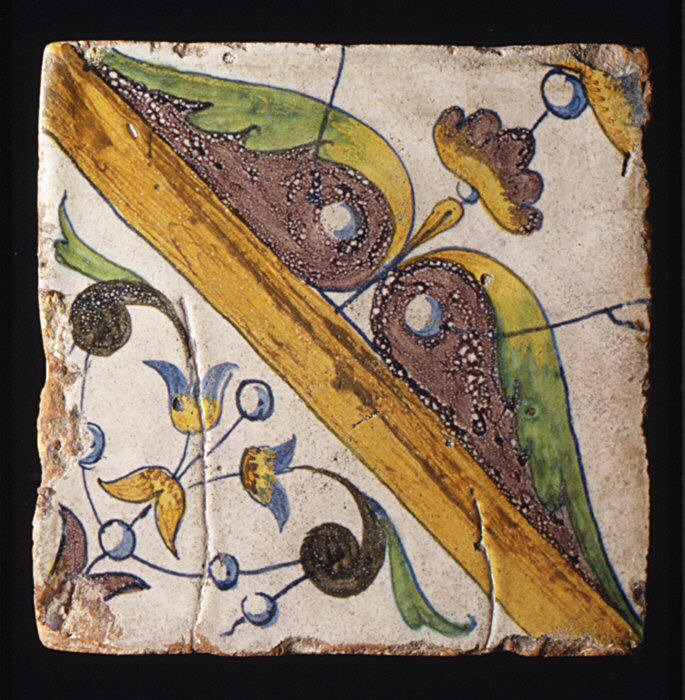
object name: tile panel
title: Panel of tiles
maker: masséot abaquesne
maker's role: maker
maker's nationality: french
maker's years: 1538-1557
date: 1549-1551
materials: faience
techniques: glazing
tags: flowers